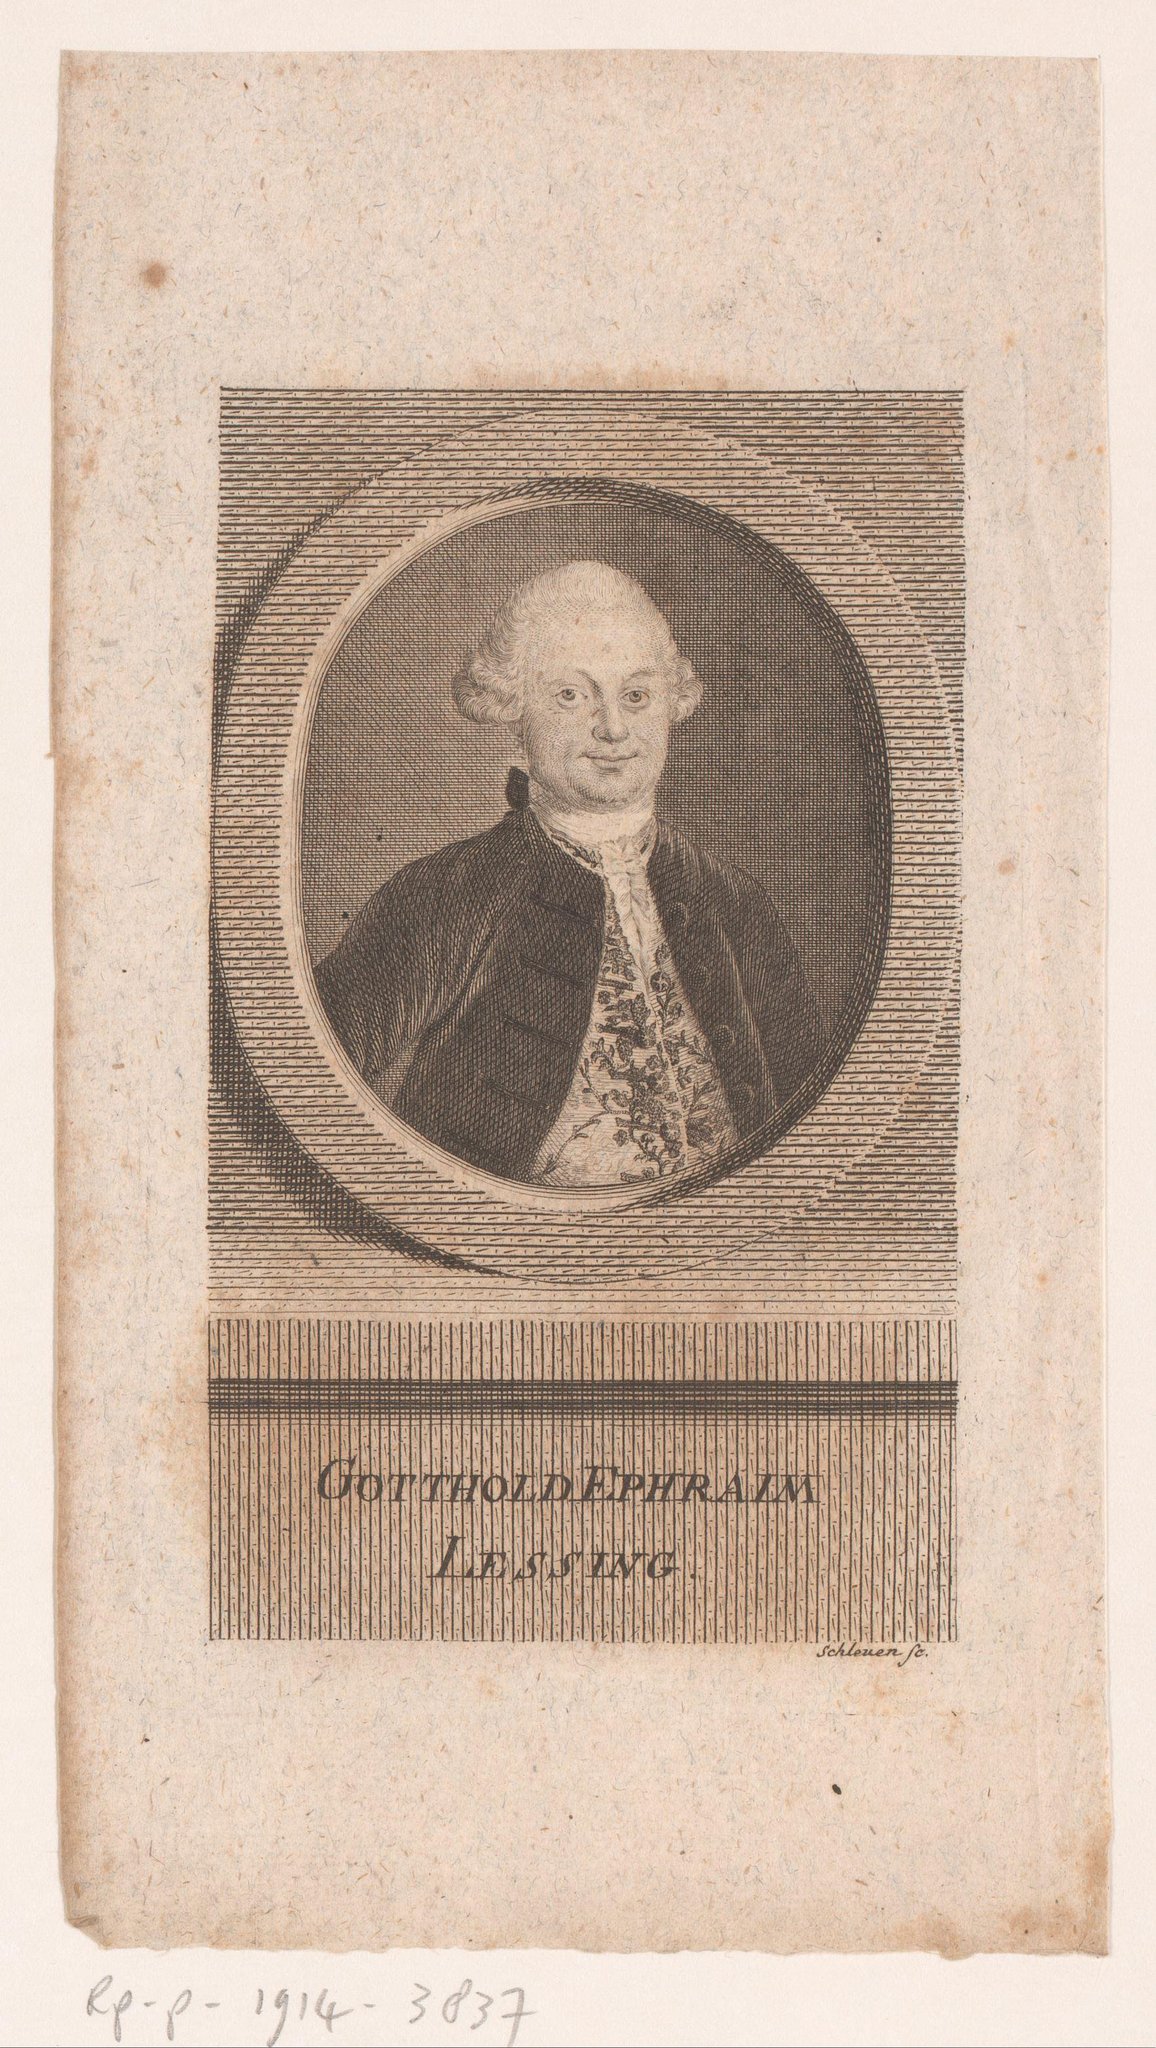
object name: print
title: Portret van Gotthold Ephraim Lessing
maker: johann david schleuen (i)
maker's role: print maker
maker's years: 1711-1774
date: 1721-1771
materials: paper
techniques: engraving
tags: historical persons, portrait of a writer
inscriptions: collector's mark: Lugt 2228